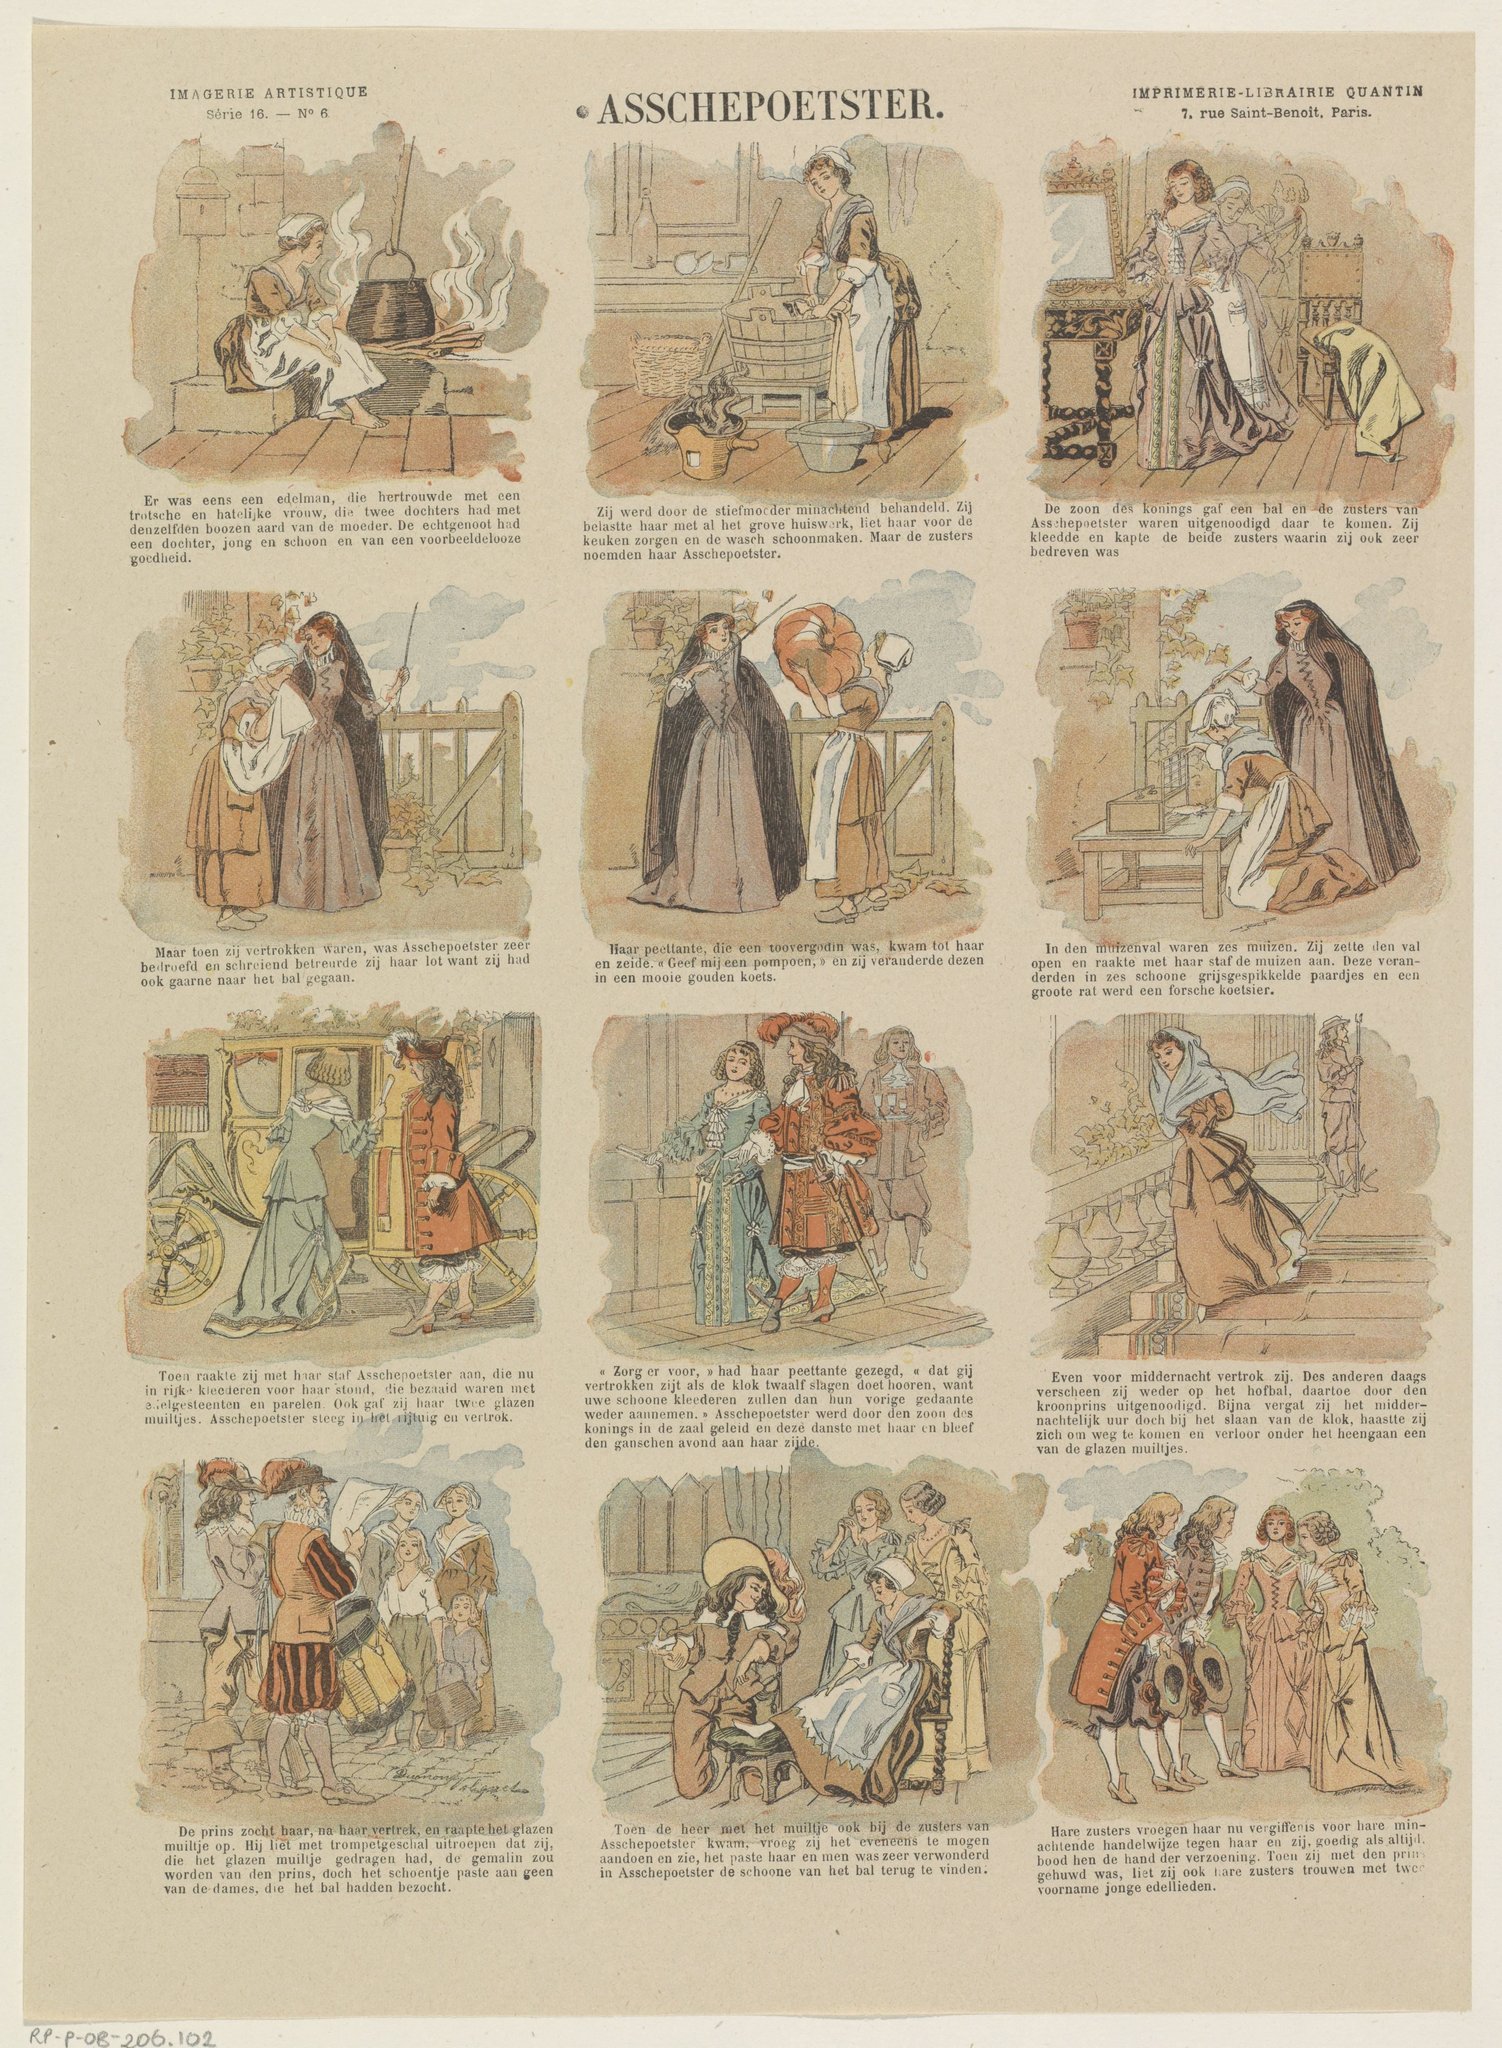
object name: popular print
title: Asschepoetster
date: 1876-1890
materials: paper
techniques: lithograph, letterpress printing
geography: paris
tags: tales and fairy tales (with title), tales and fairy tales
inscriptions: collector's mark: Lugt 2760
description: Blad met 12 voorstellingen uit het sprookje van Assepoester. Onder elke afbeelding een onderschrift. Genummerd linksboven: Série 16. - No. 6.